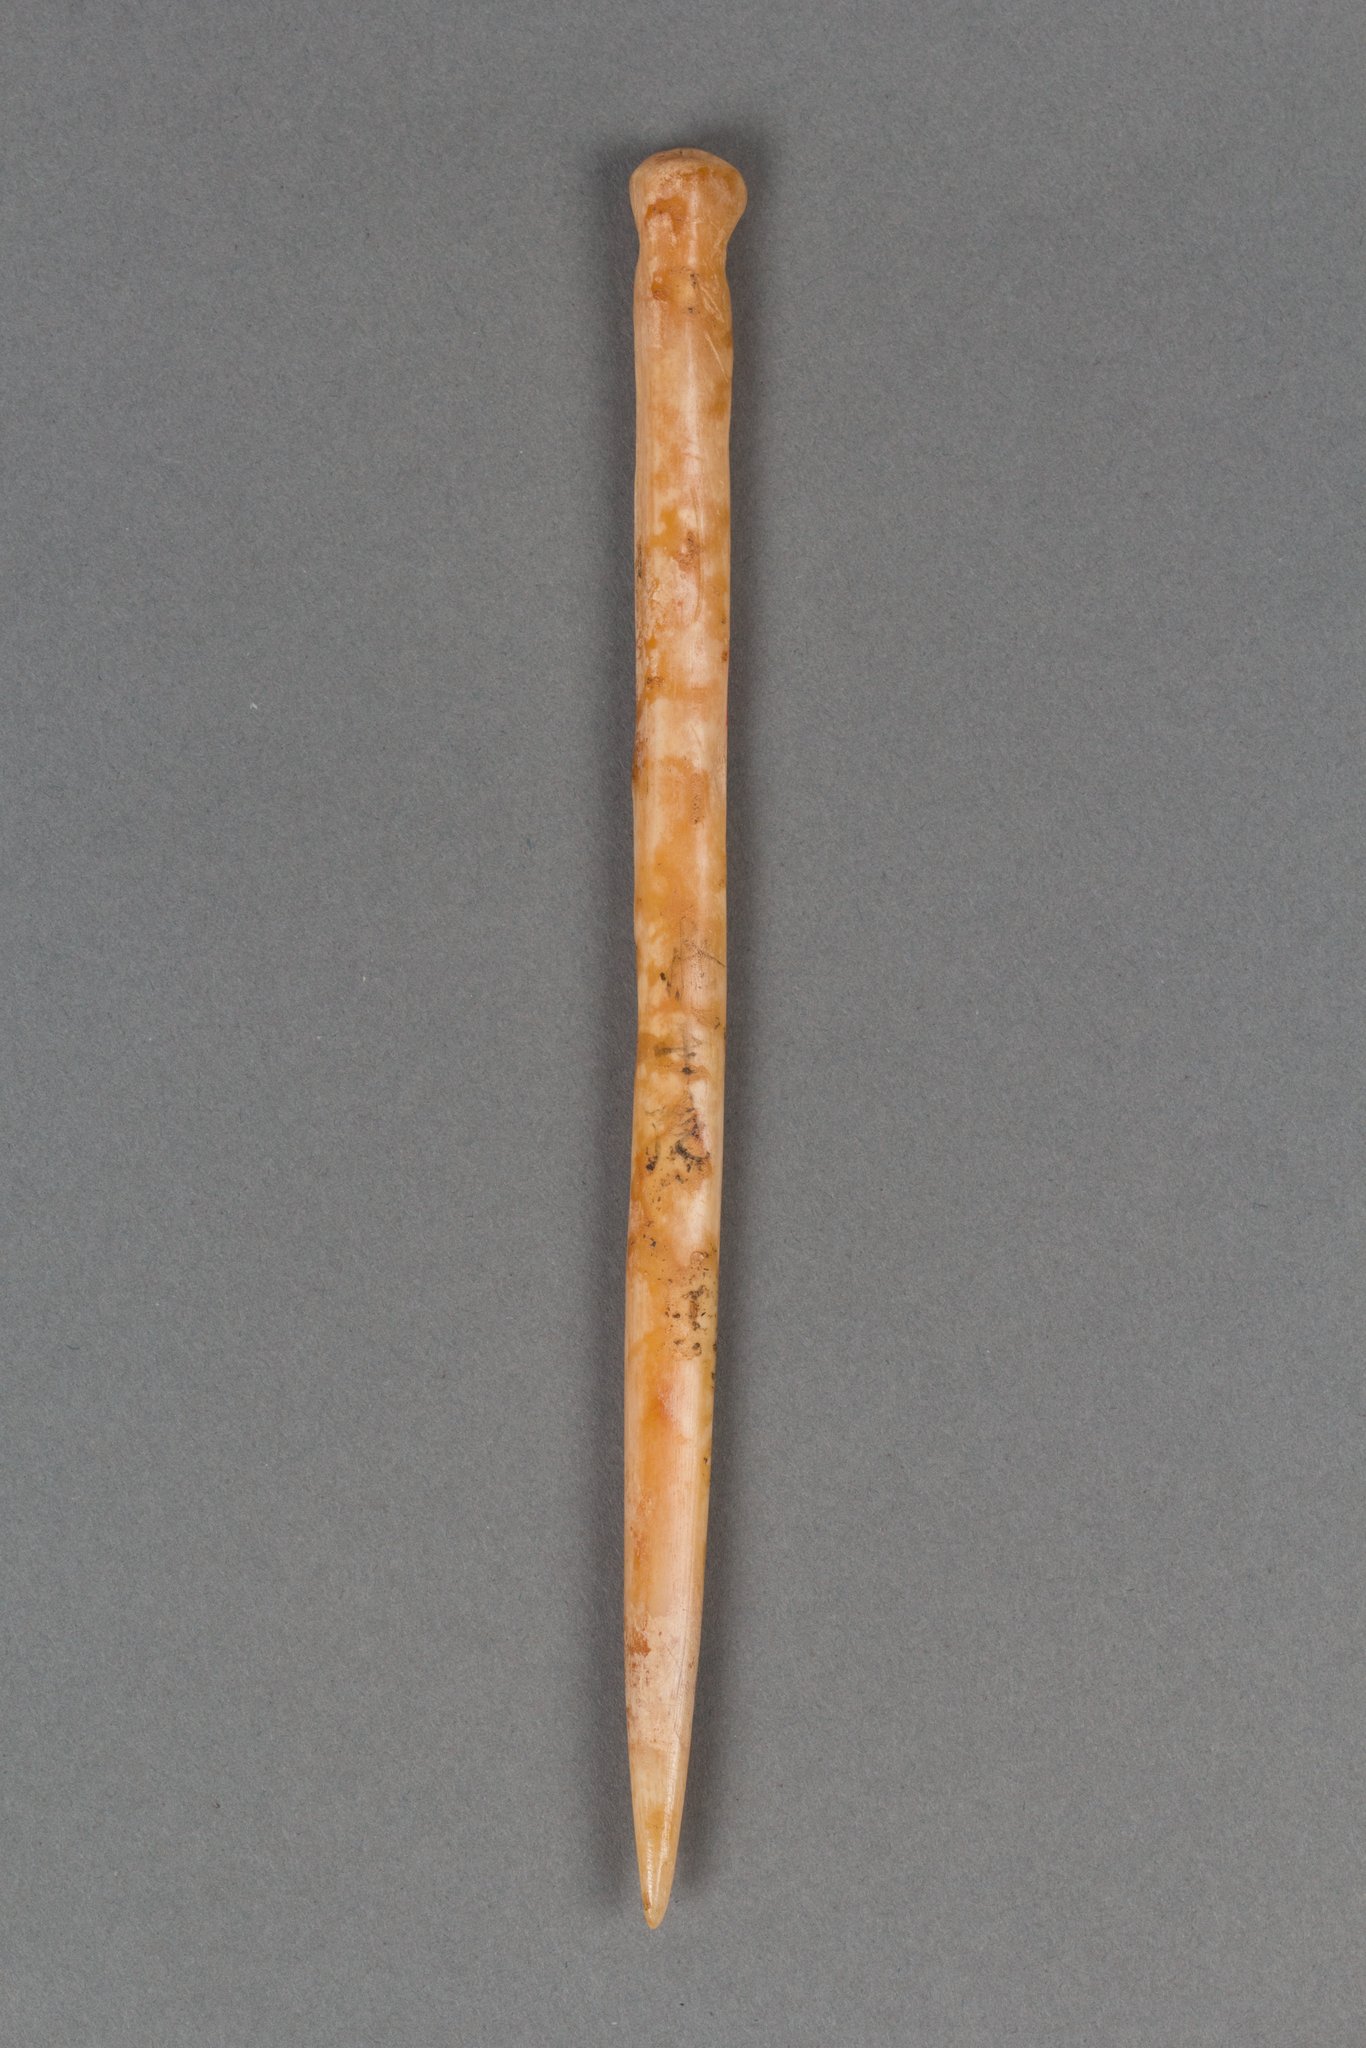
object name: hairpin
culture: japanese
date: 1200-200 BCE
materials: bone